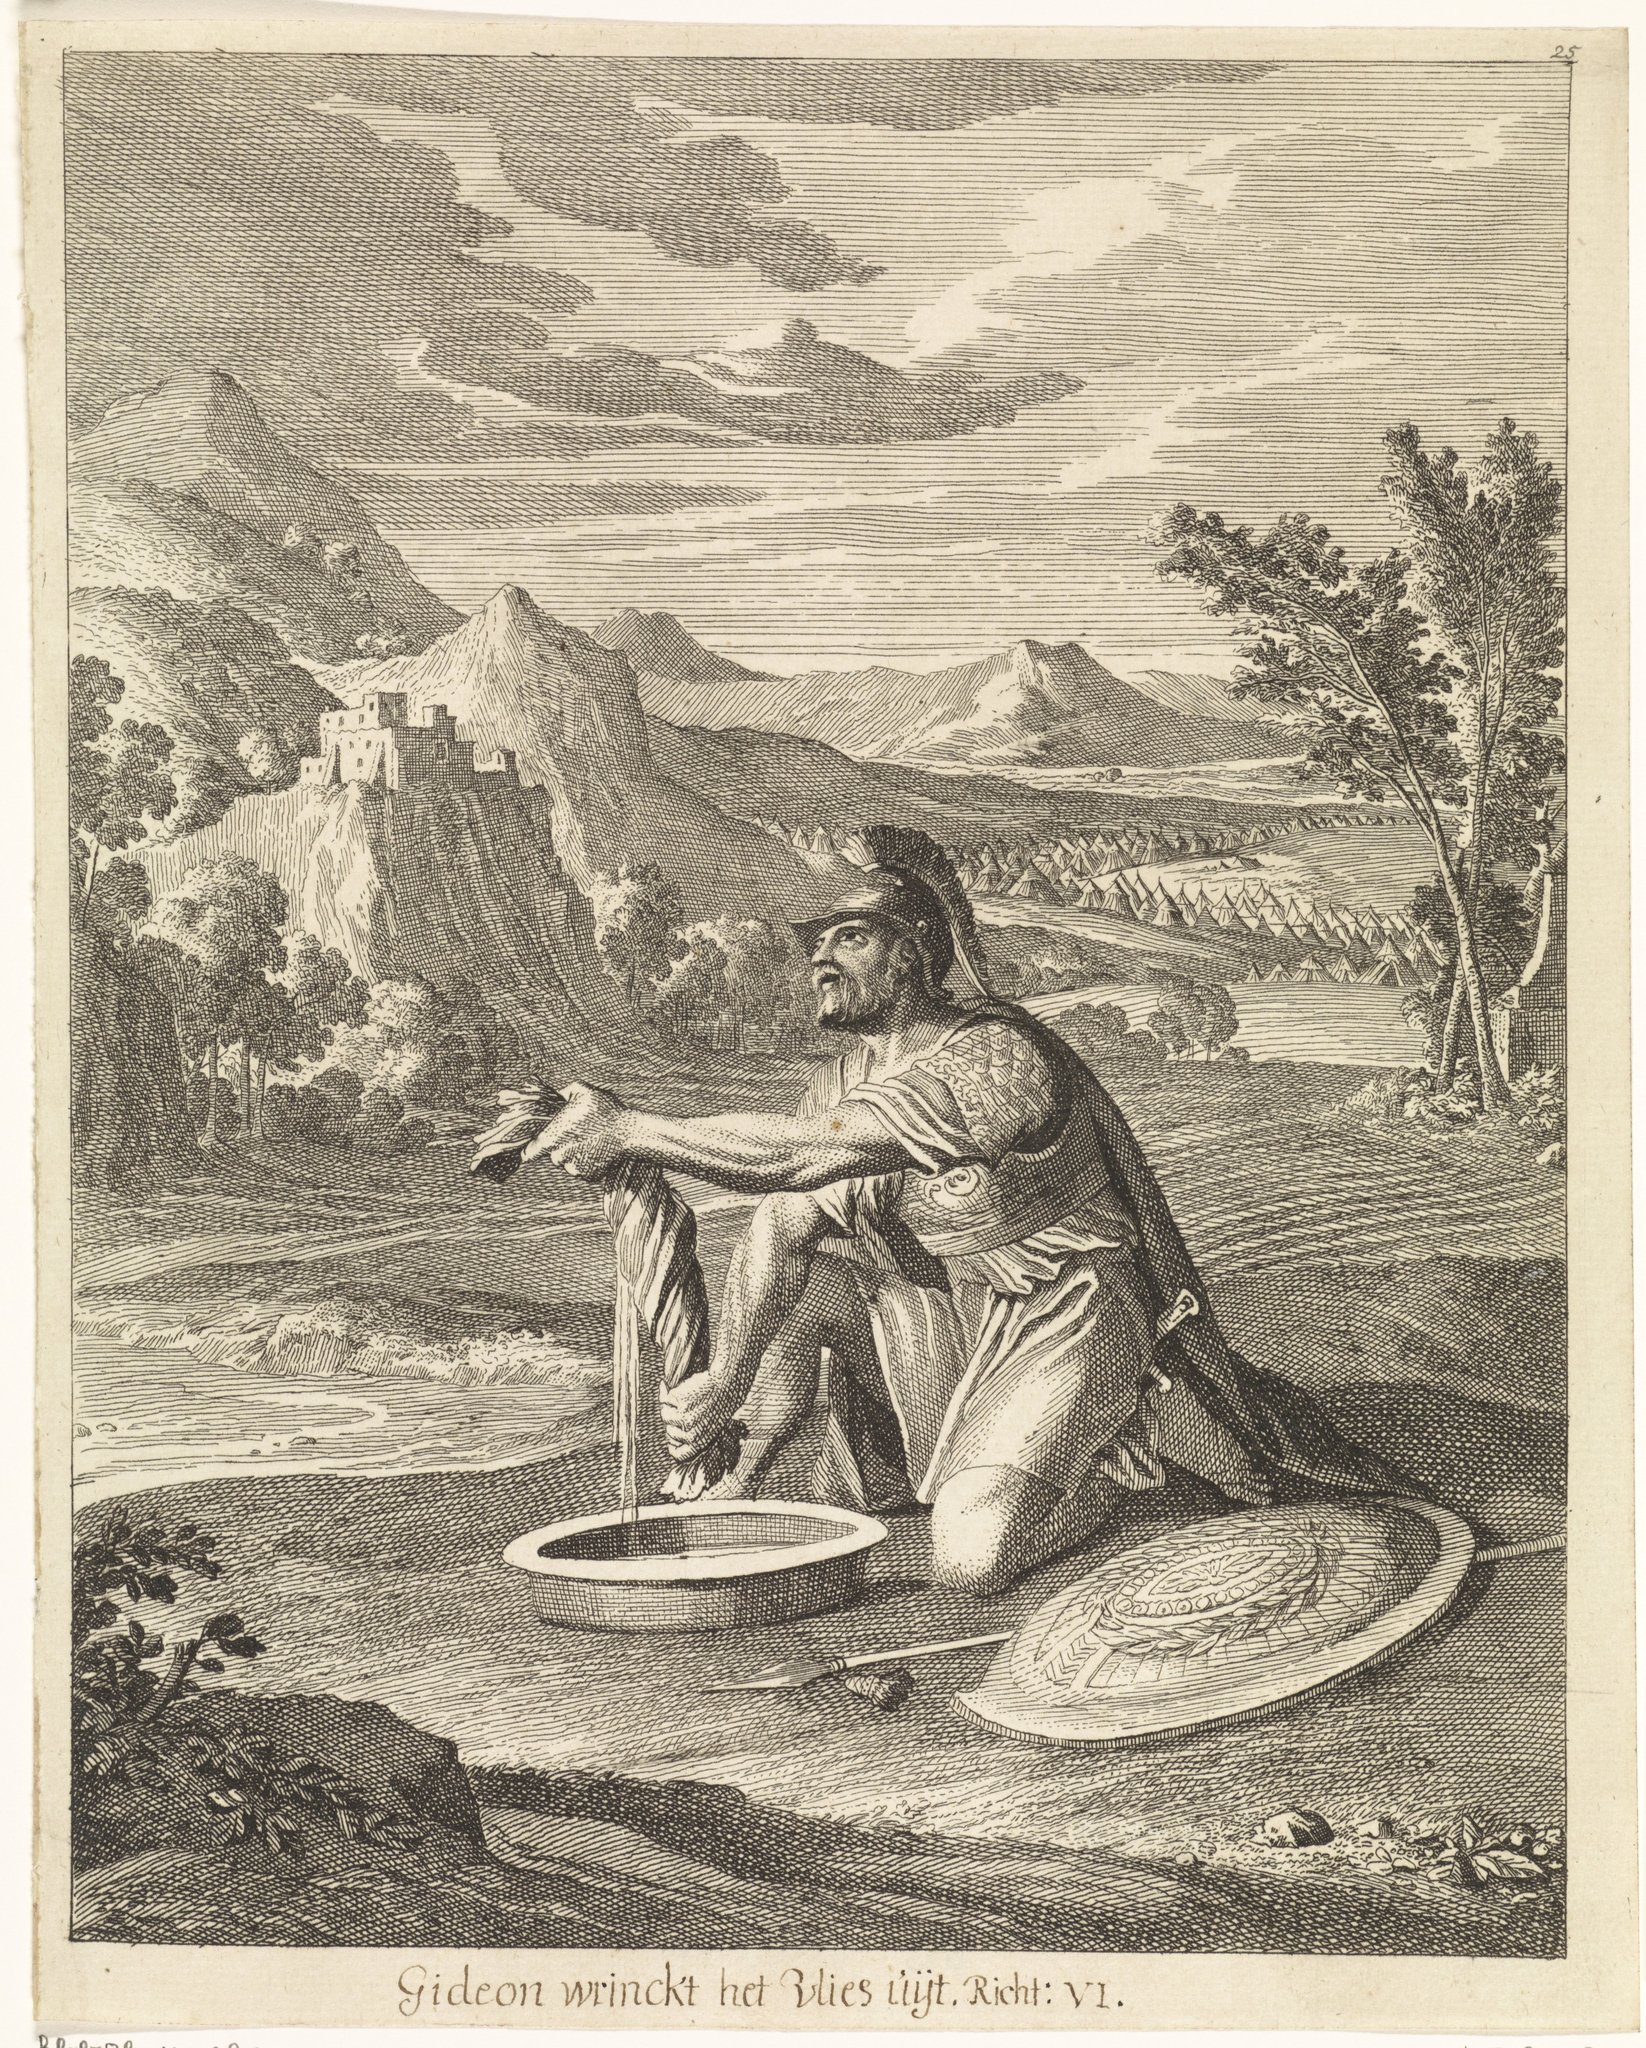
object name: print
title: Gideon wringt de natte schaapsvacht uit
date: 1708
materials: paper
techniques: etching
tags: gideon presses the fleece and wrings out a bowl full of water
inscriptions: collector's mark: Lugt 2228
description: Proefdruk van een prent welke is opgenomen als illustratie in: Historiae Celebriores Veteris Testamenti. Christoph Weigel, 1708.